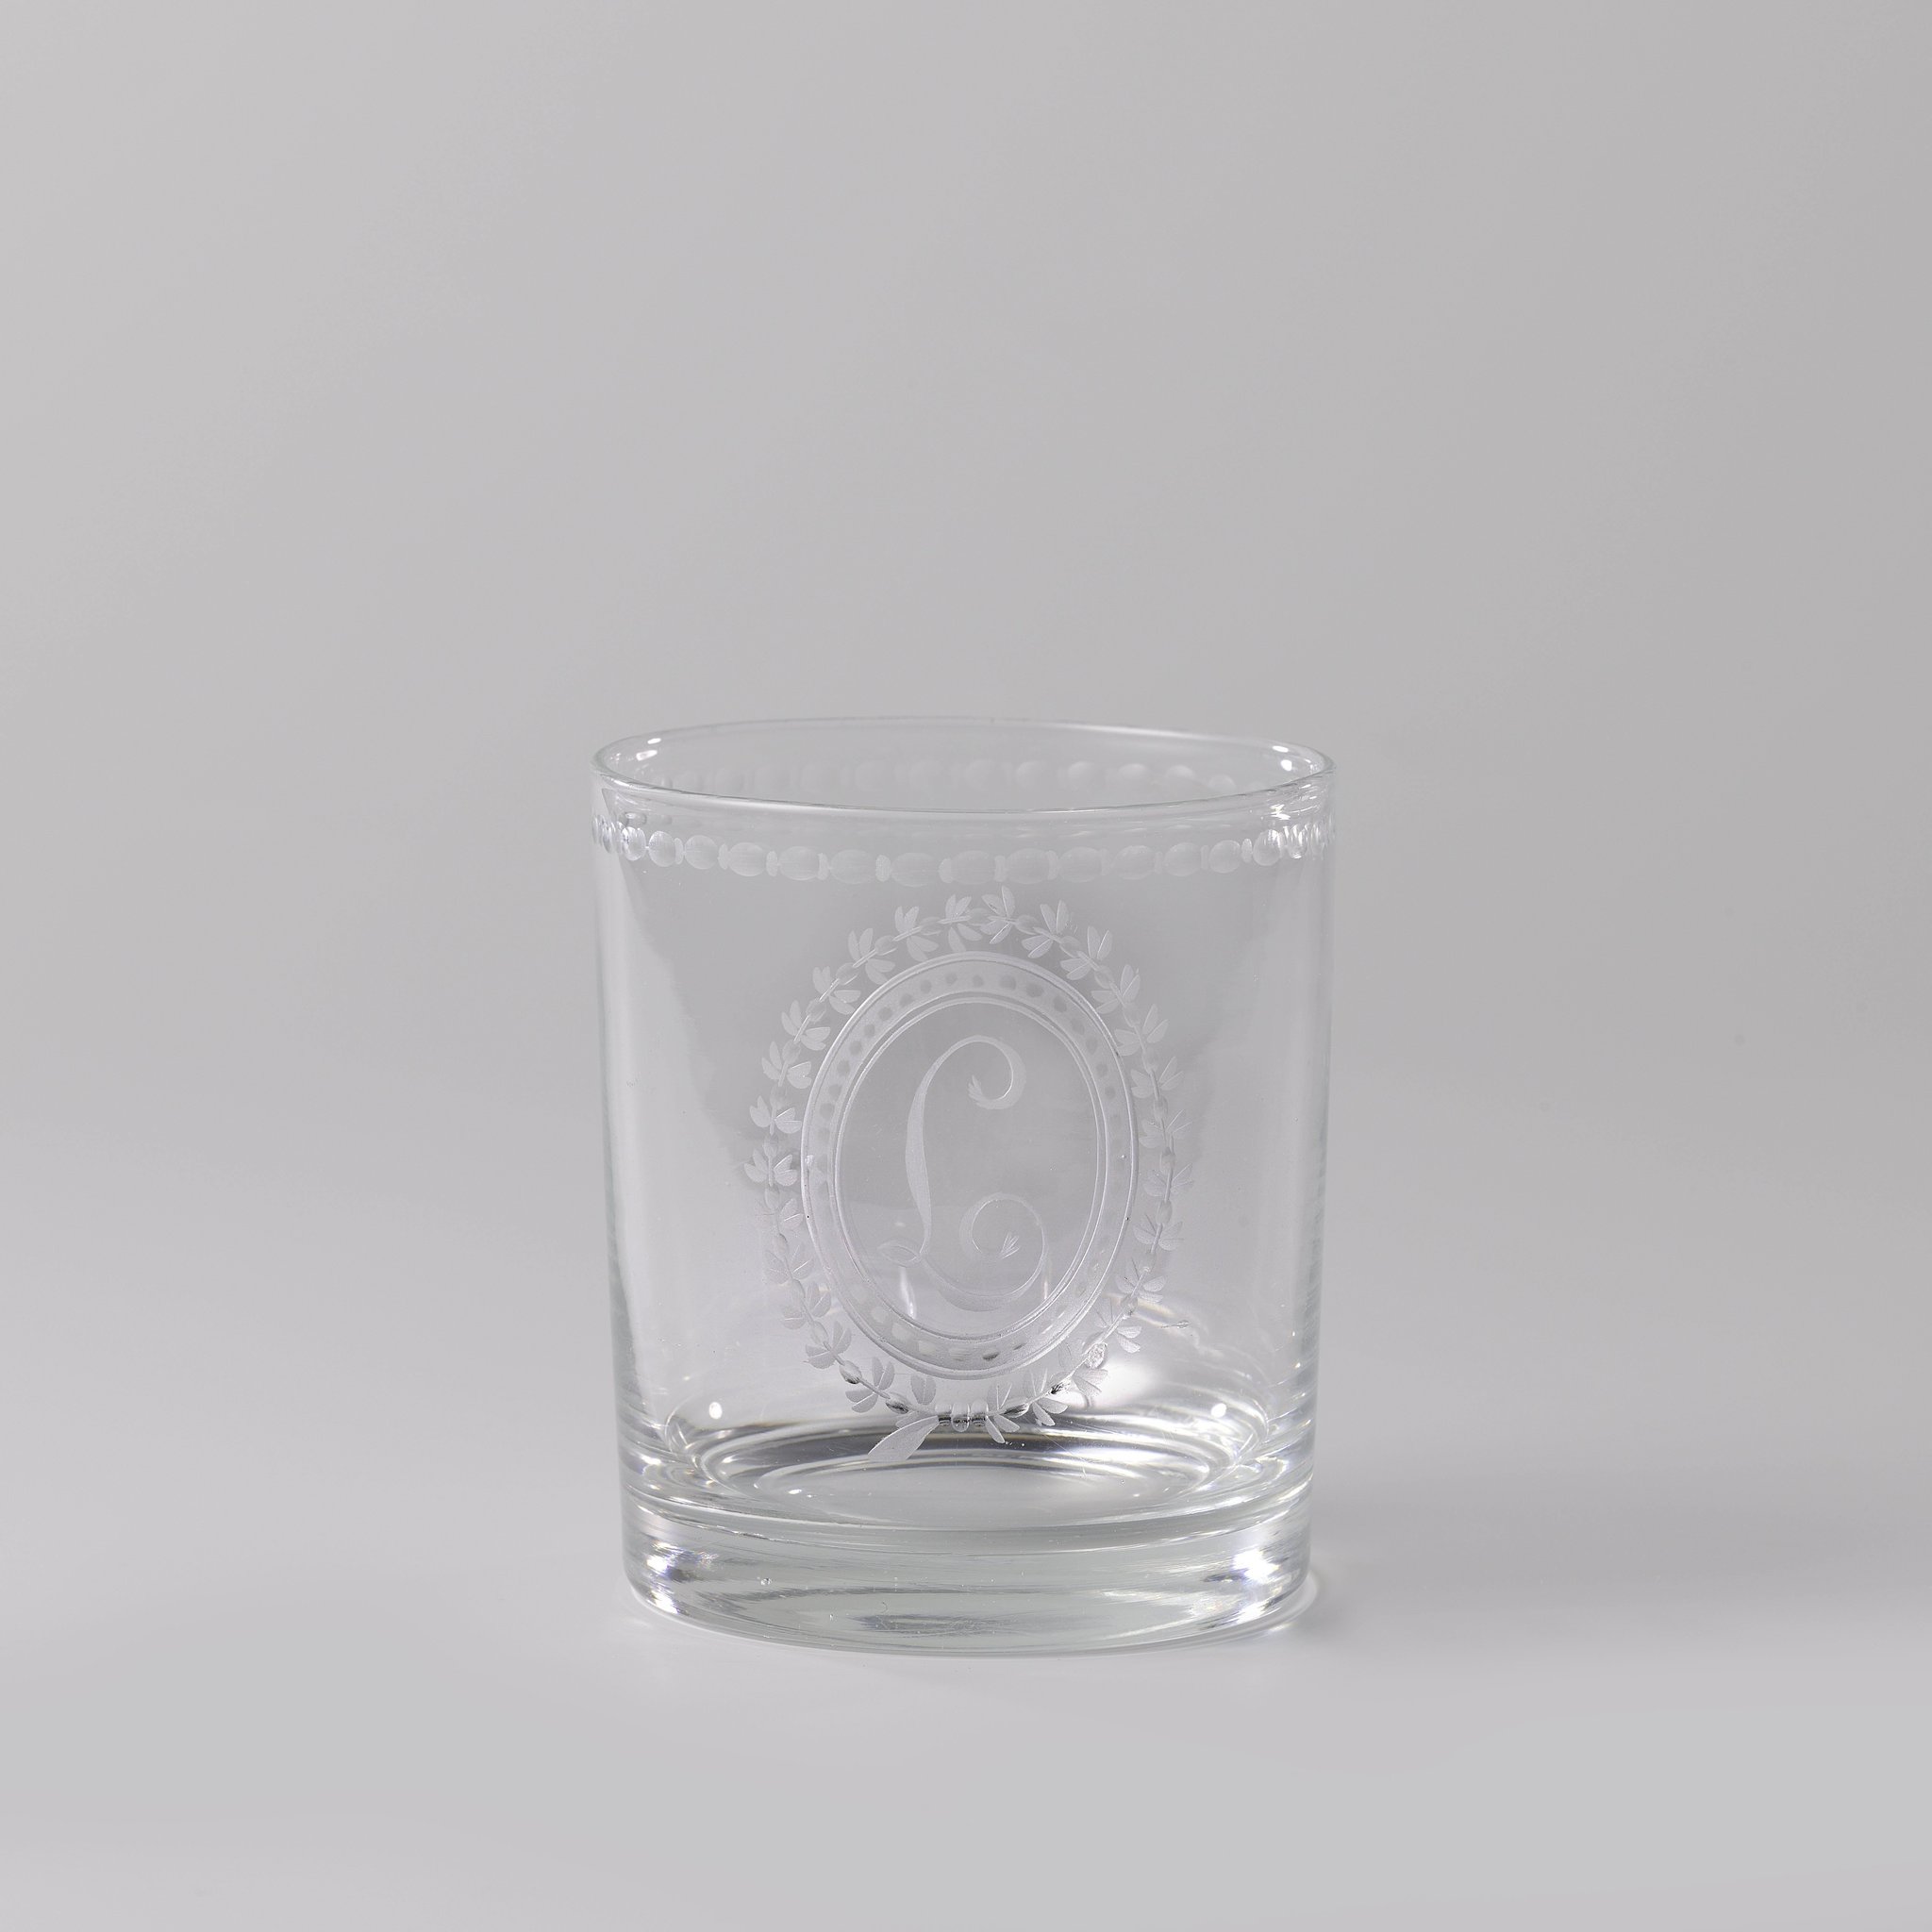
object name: cup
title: Beker met een medaillon met de letter "L"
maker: Anonymous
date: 1790-1810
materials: glass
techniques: glassblowing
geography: france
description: Platte, concaaf geslepen bodem, cylindervormig lichaam waarop een ovaal medaillon in Lodewijk XVI stijl, omgeven door een bladrank. In het medaillon de letter 'L'. Langs de bovenrand een eierlijst.